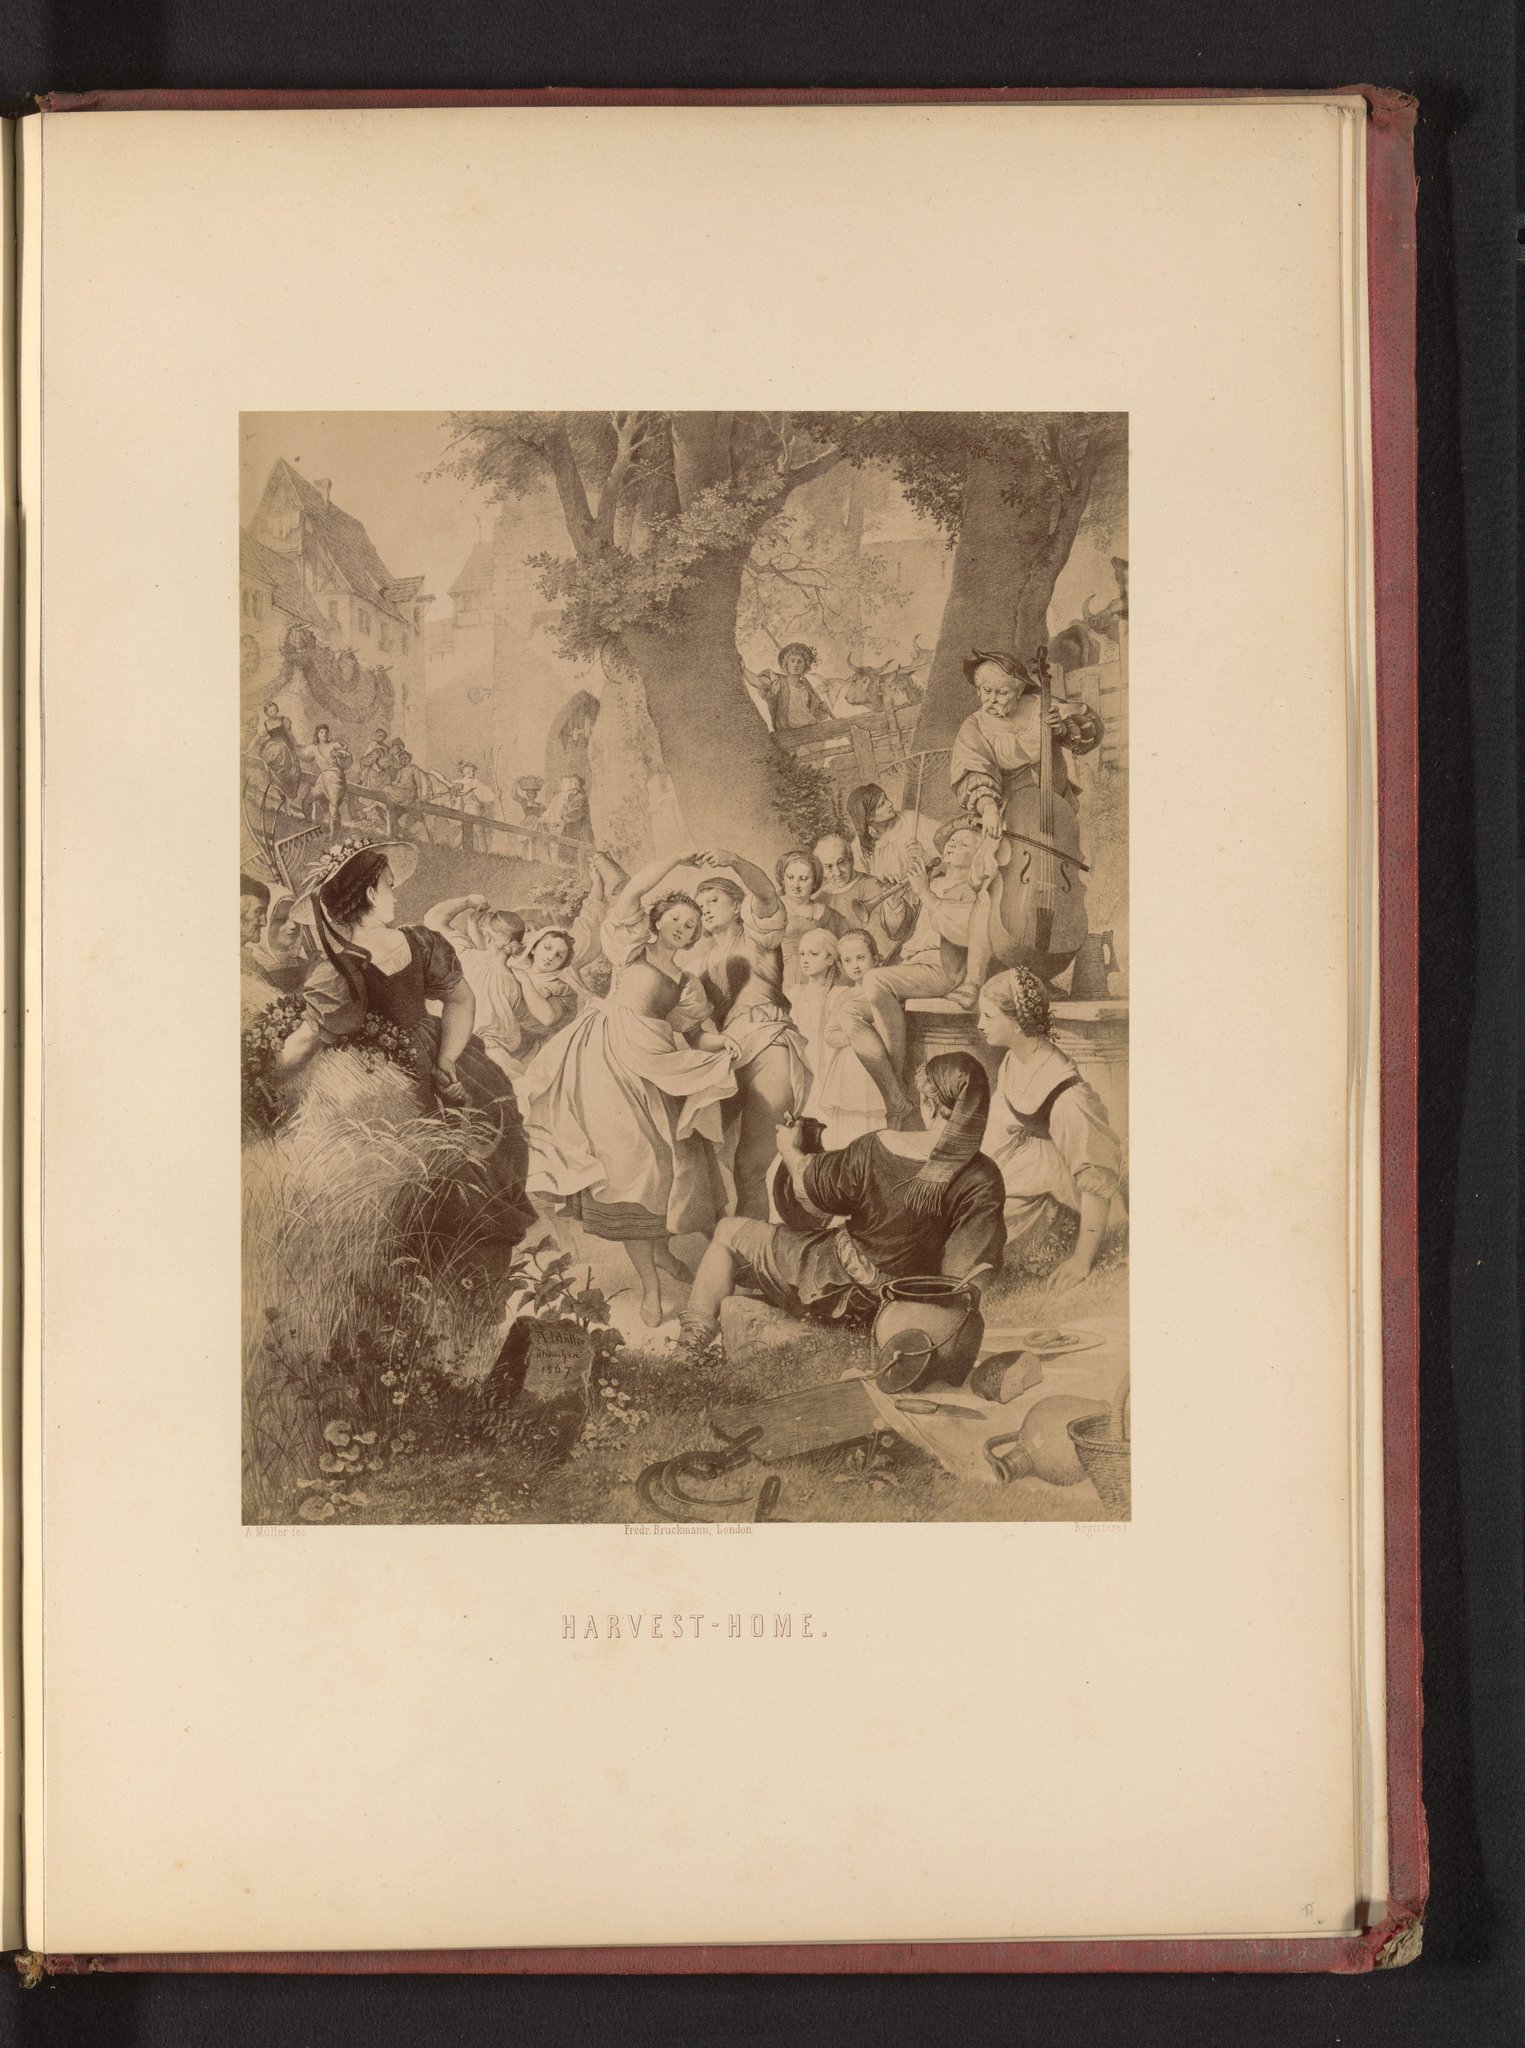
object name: page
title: Harvest-home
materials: photographic support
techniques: albumen print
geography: london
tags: harvest festivities (+ dancing ~ festive activities)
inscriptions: inscription: ‘Registered.’